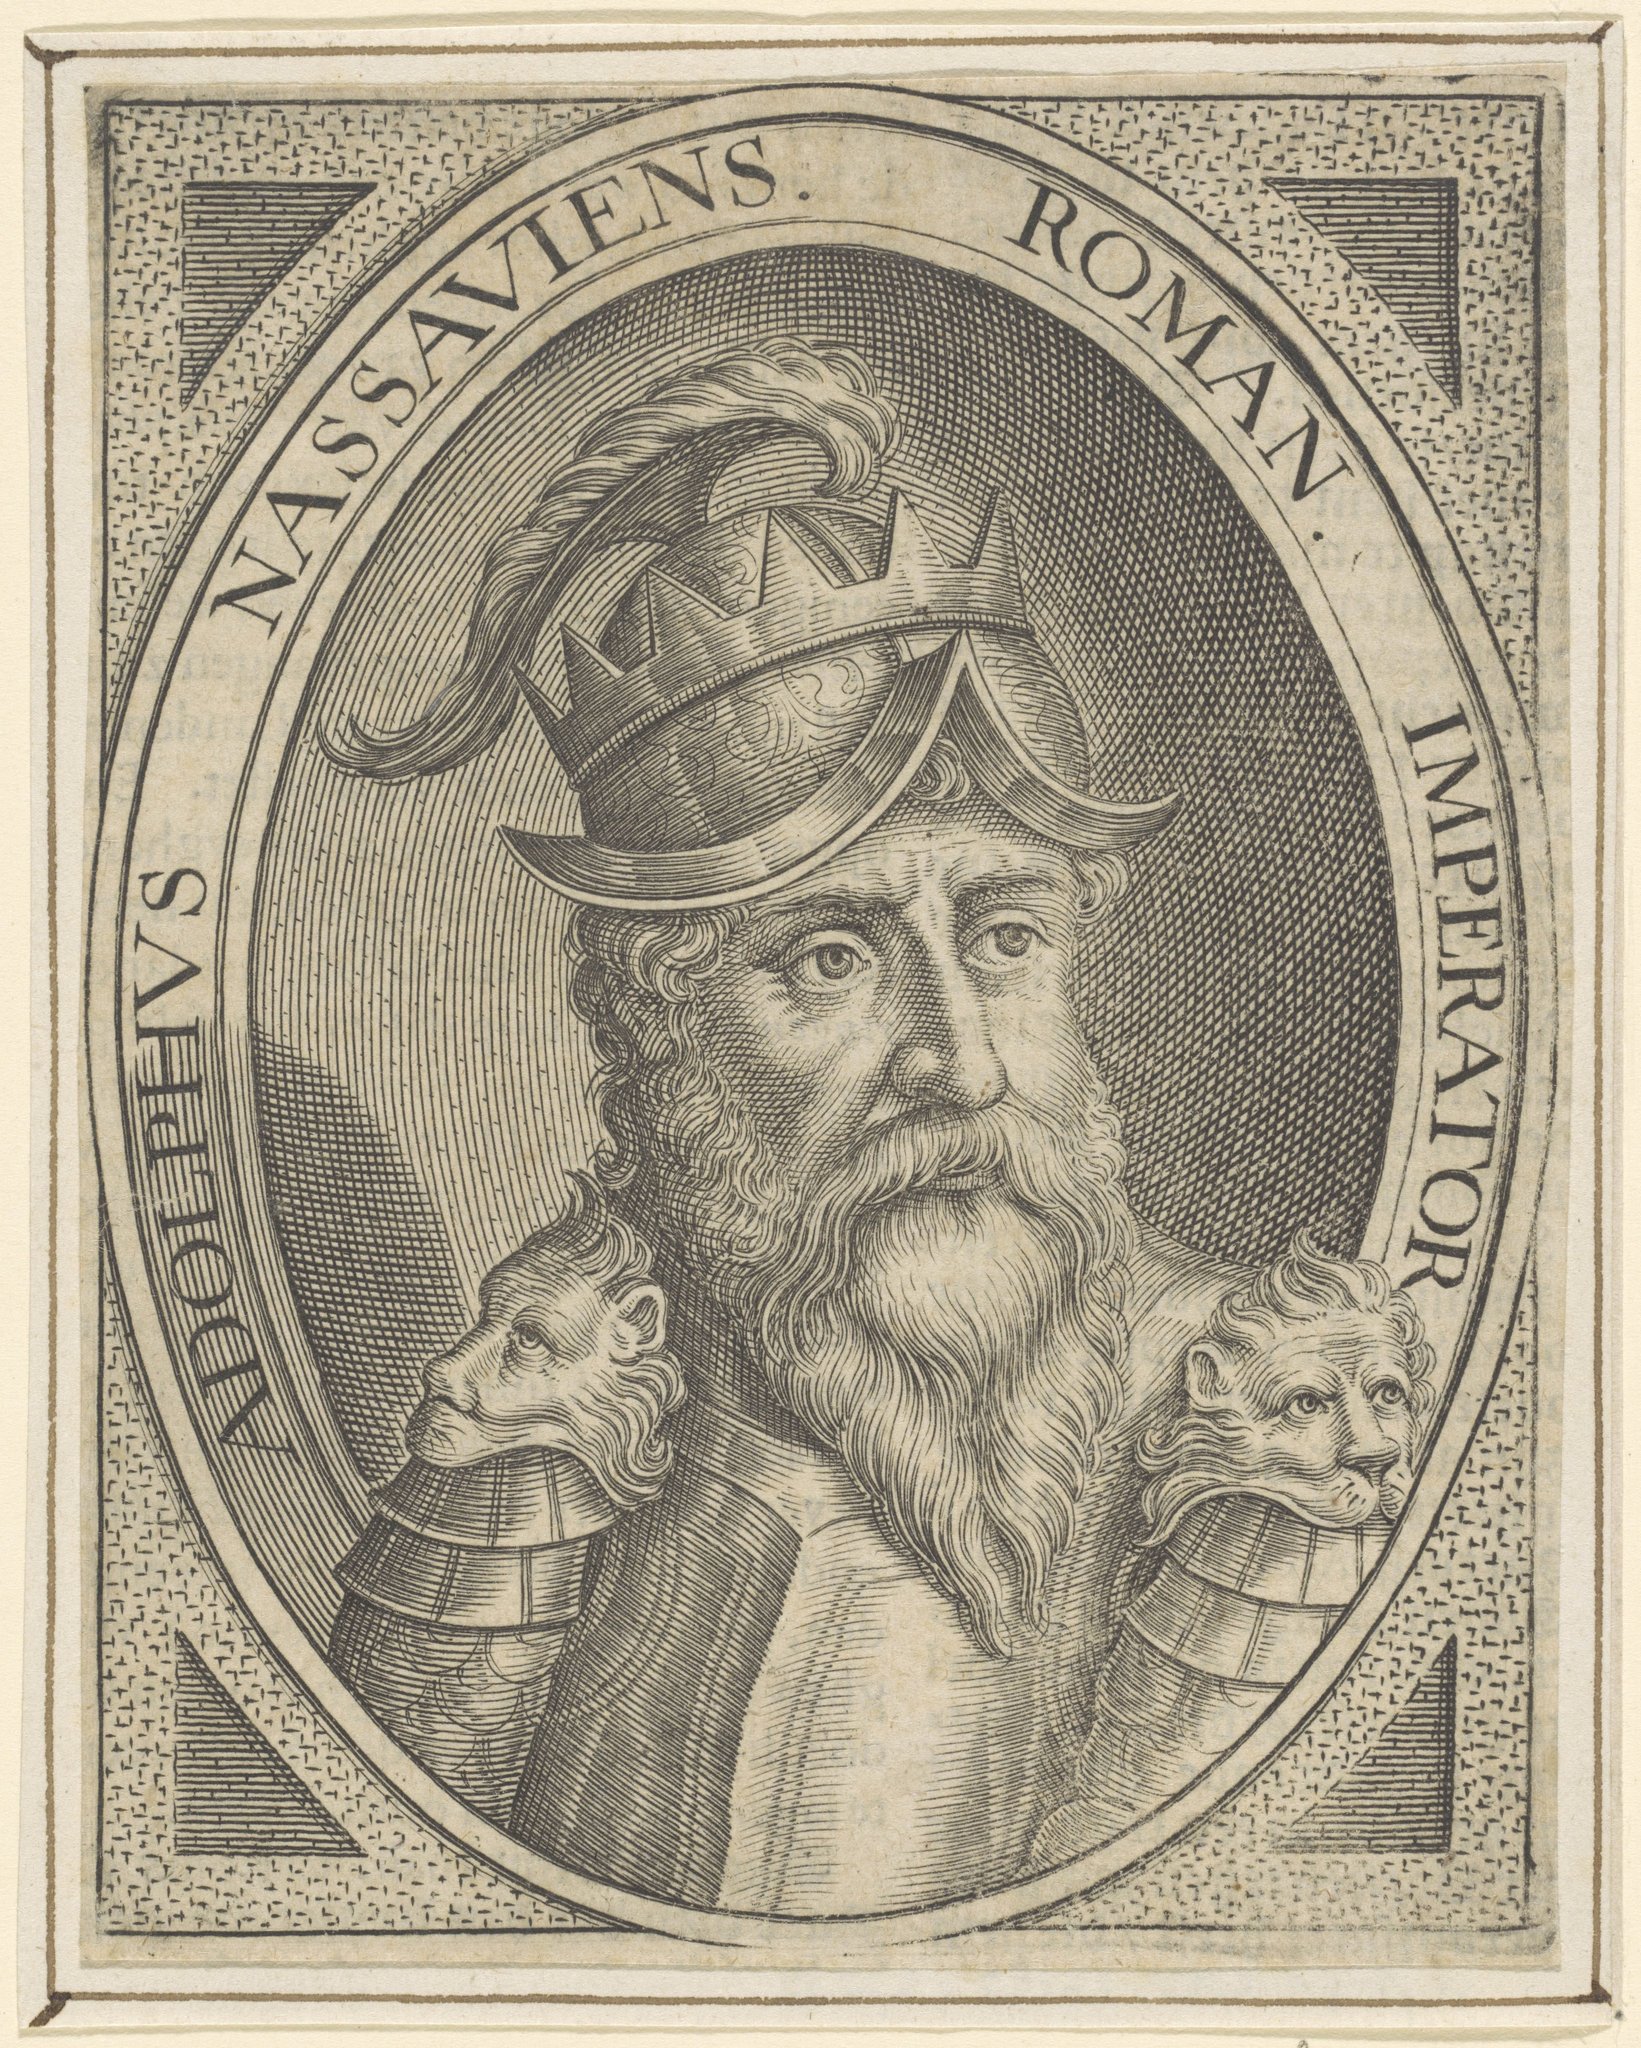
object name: print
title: Portret van Adolf, graaf van Nassau en Rooms-Duits koning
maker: Anonymous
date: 1600-1699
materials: paper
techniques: engraving, etching, letterpress printing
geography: low countries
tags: gelnheim, koning, adolf (graaf van nassau en rooms-duits koning)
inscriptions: collector's mark: Lugt 963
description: De hier vermelde titel verwijst naar de hoogst verkregen titel van de geportretteerde, niet per se naar de titel die de geportretteerde op deze voorstelling draagt.